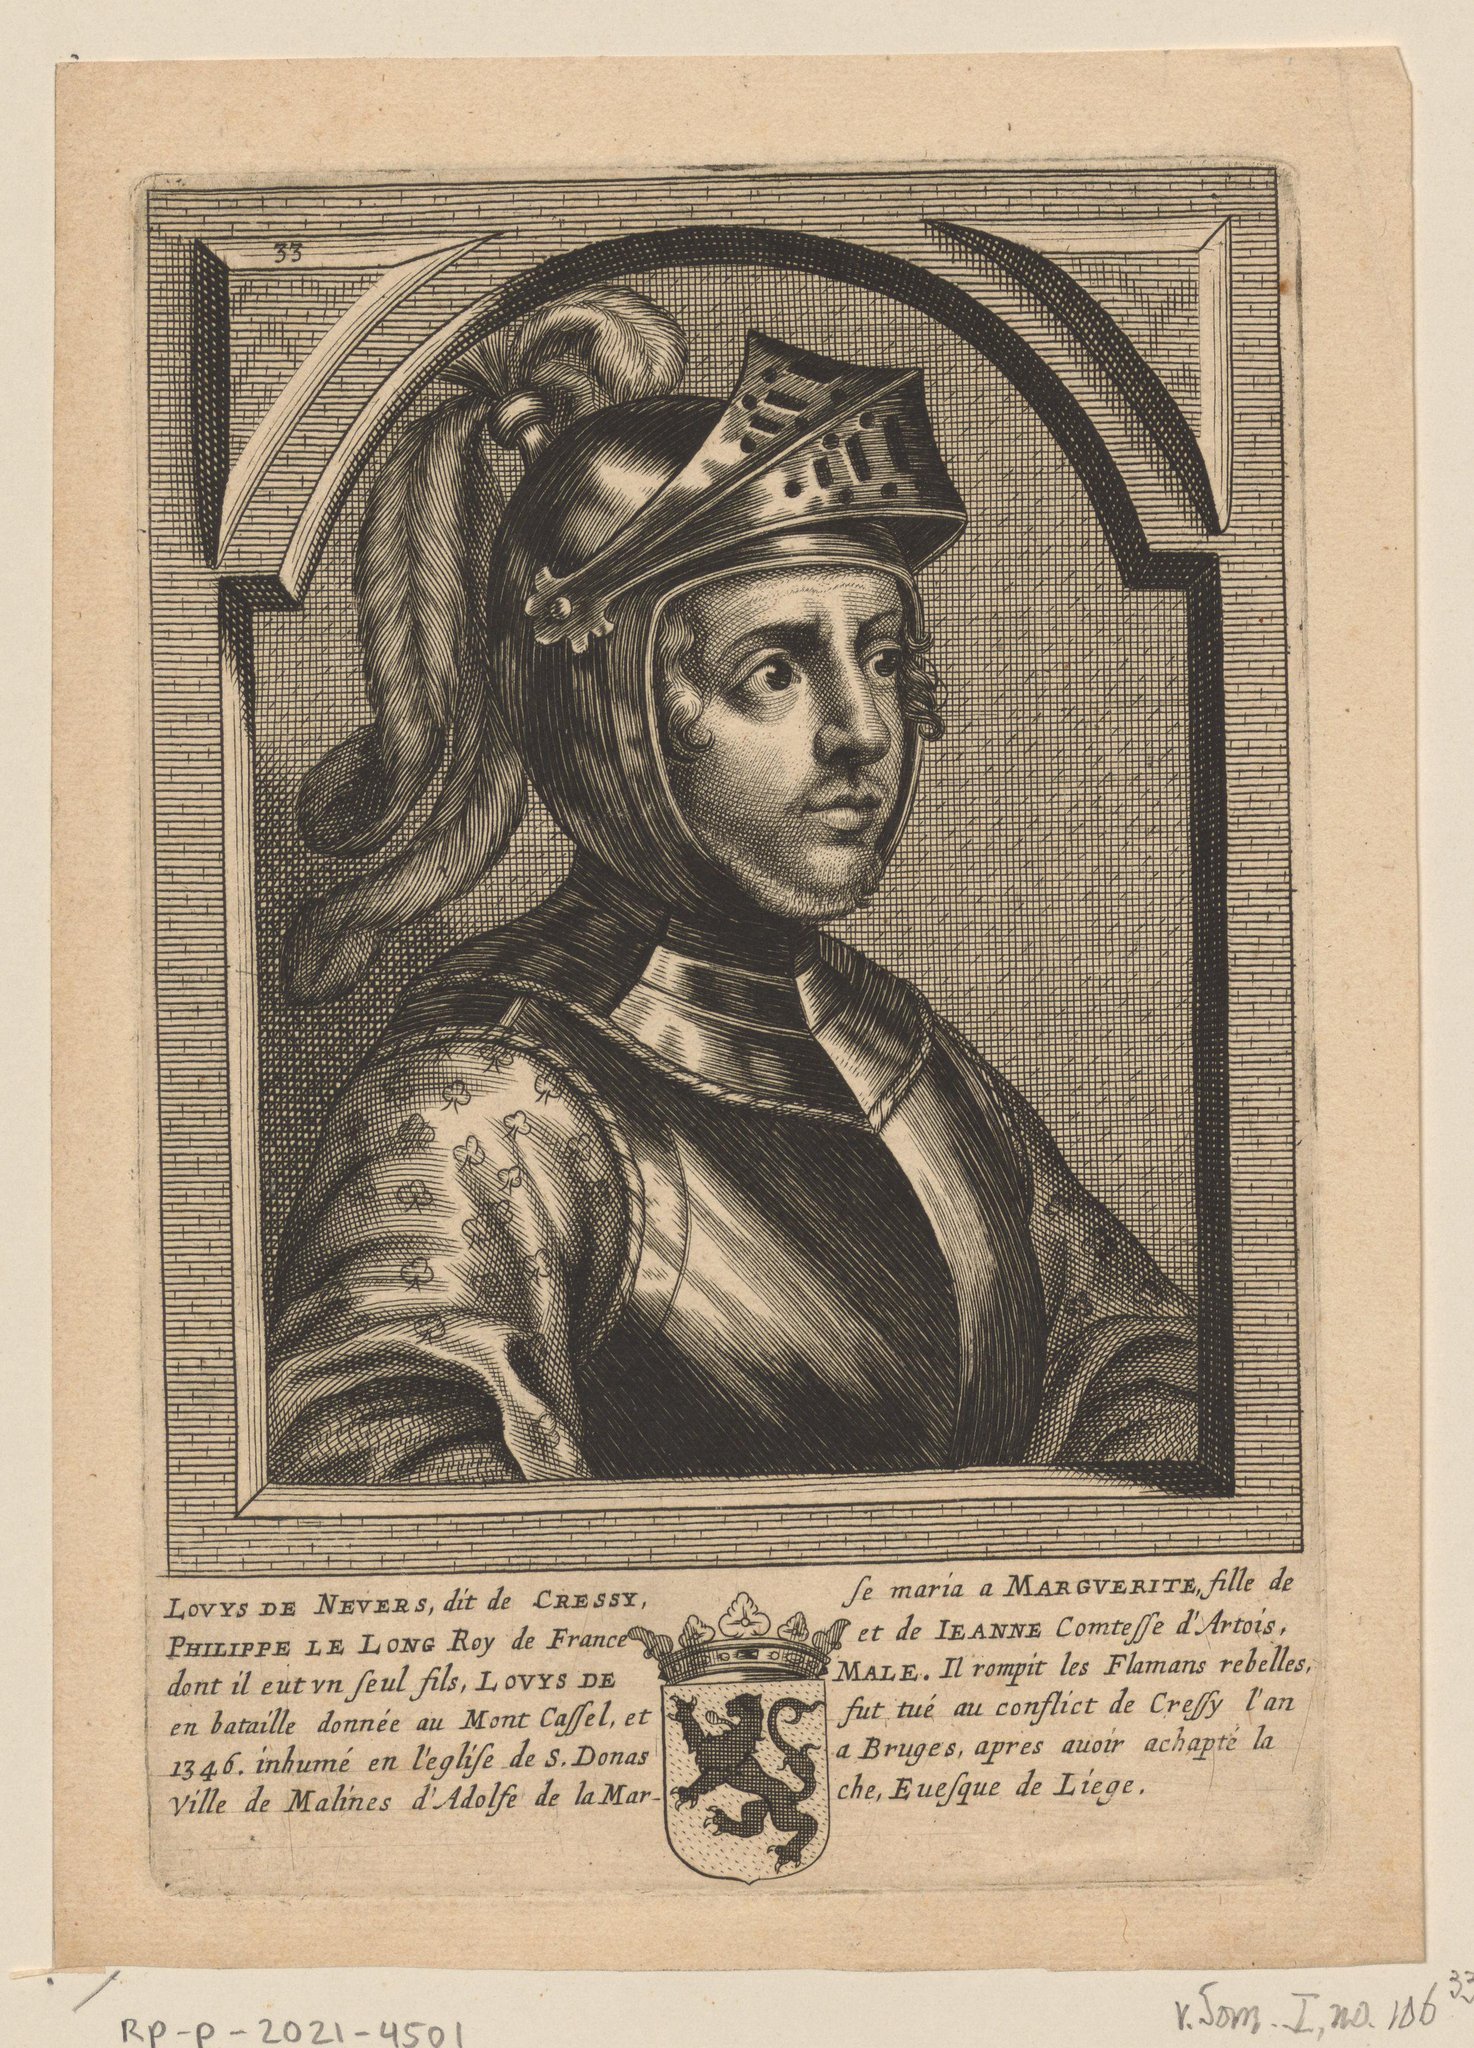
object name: print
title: Portret van Lodewijk I van Vlaanderen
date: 1663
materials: paper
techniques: engraving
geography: antwerp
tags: earl, armour, historical persons, armorial bearing, heraldry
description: Linksboven genummerd: 33. Met onderschrift in het Frans.